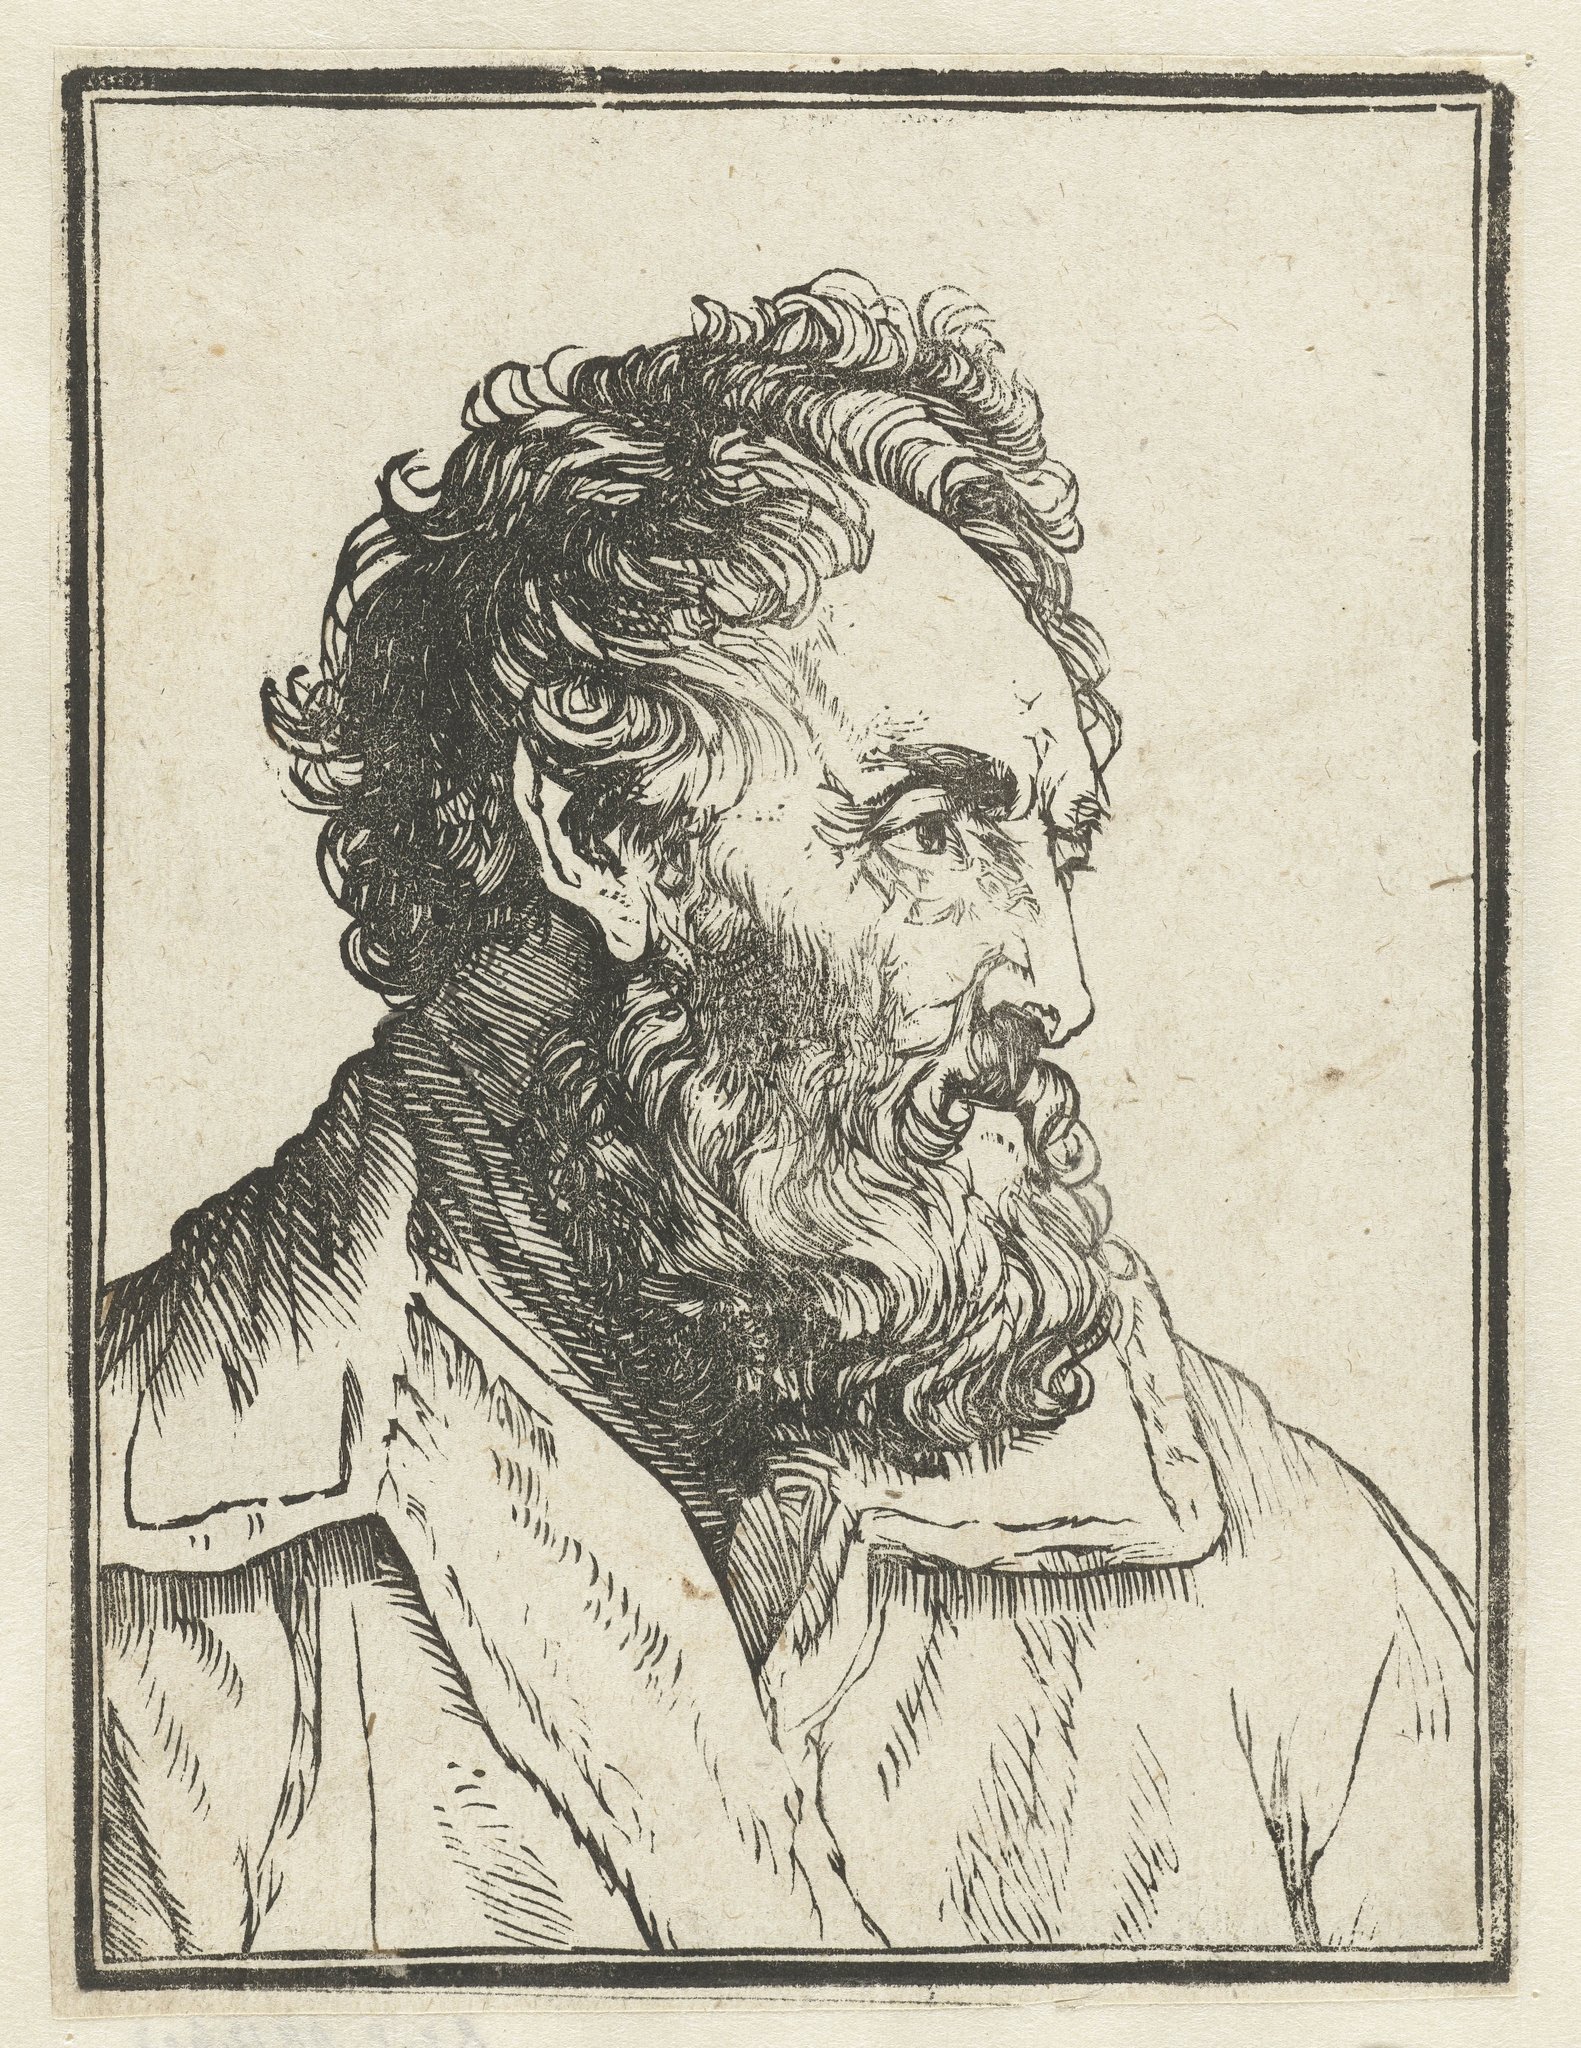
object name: print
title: Borstbeeld van een man met baard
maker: Anonymous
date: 1625-1674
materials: paper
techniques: woodcut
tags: adult man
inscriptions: collector's mark: Lugt 2228a